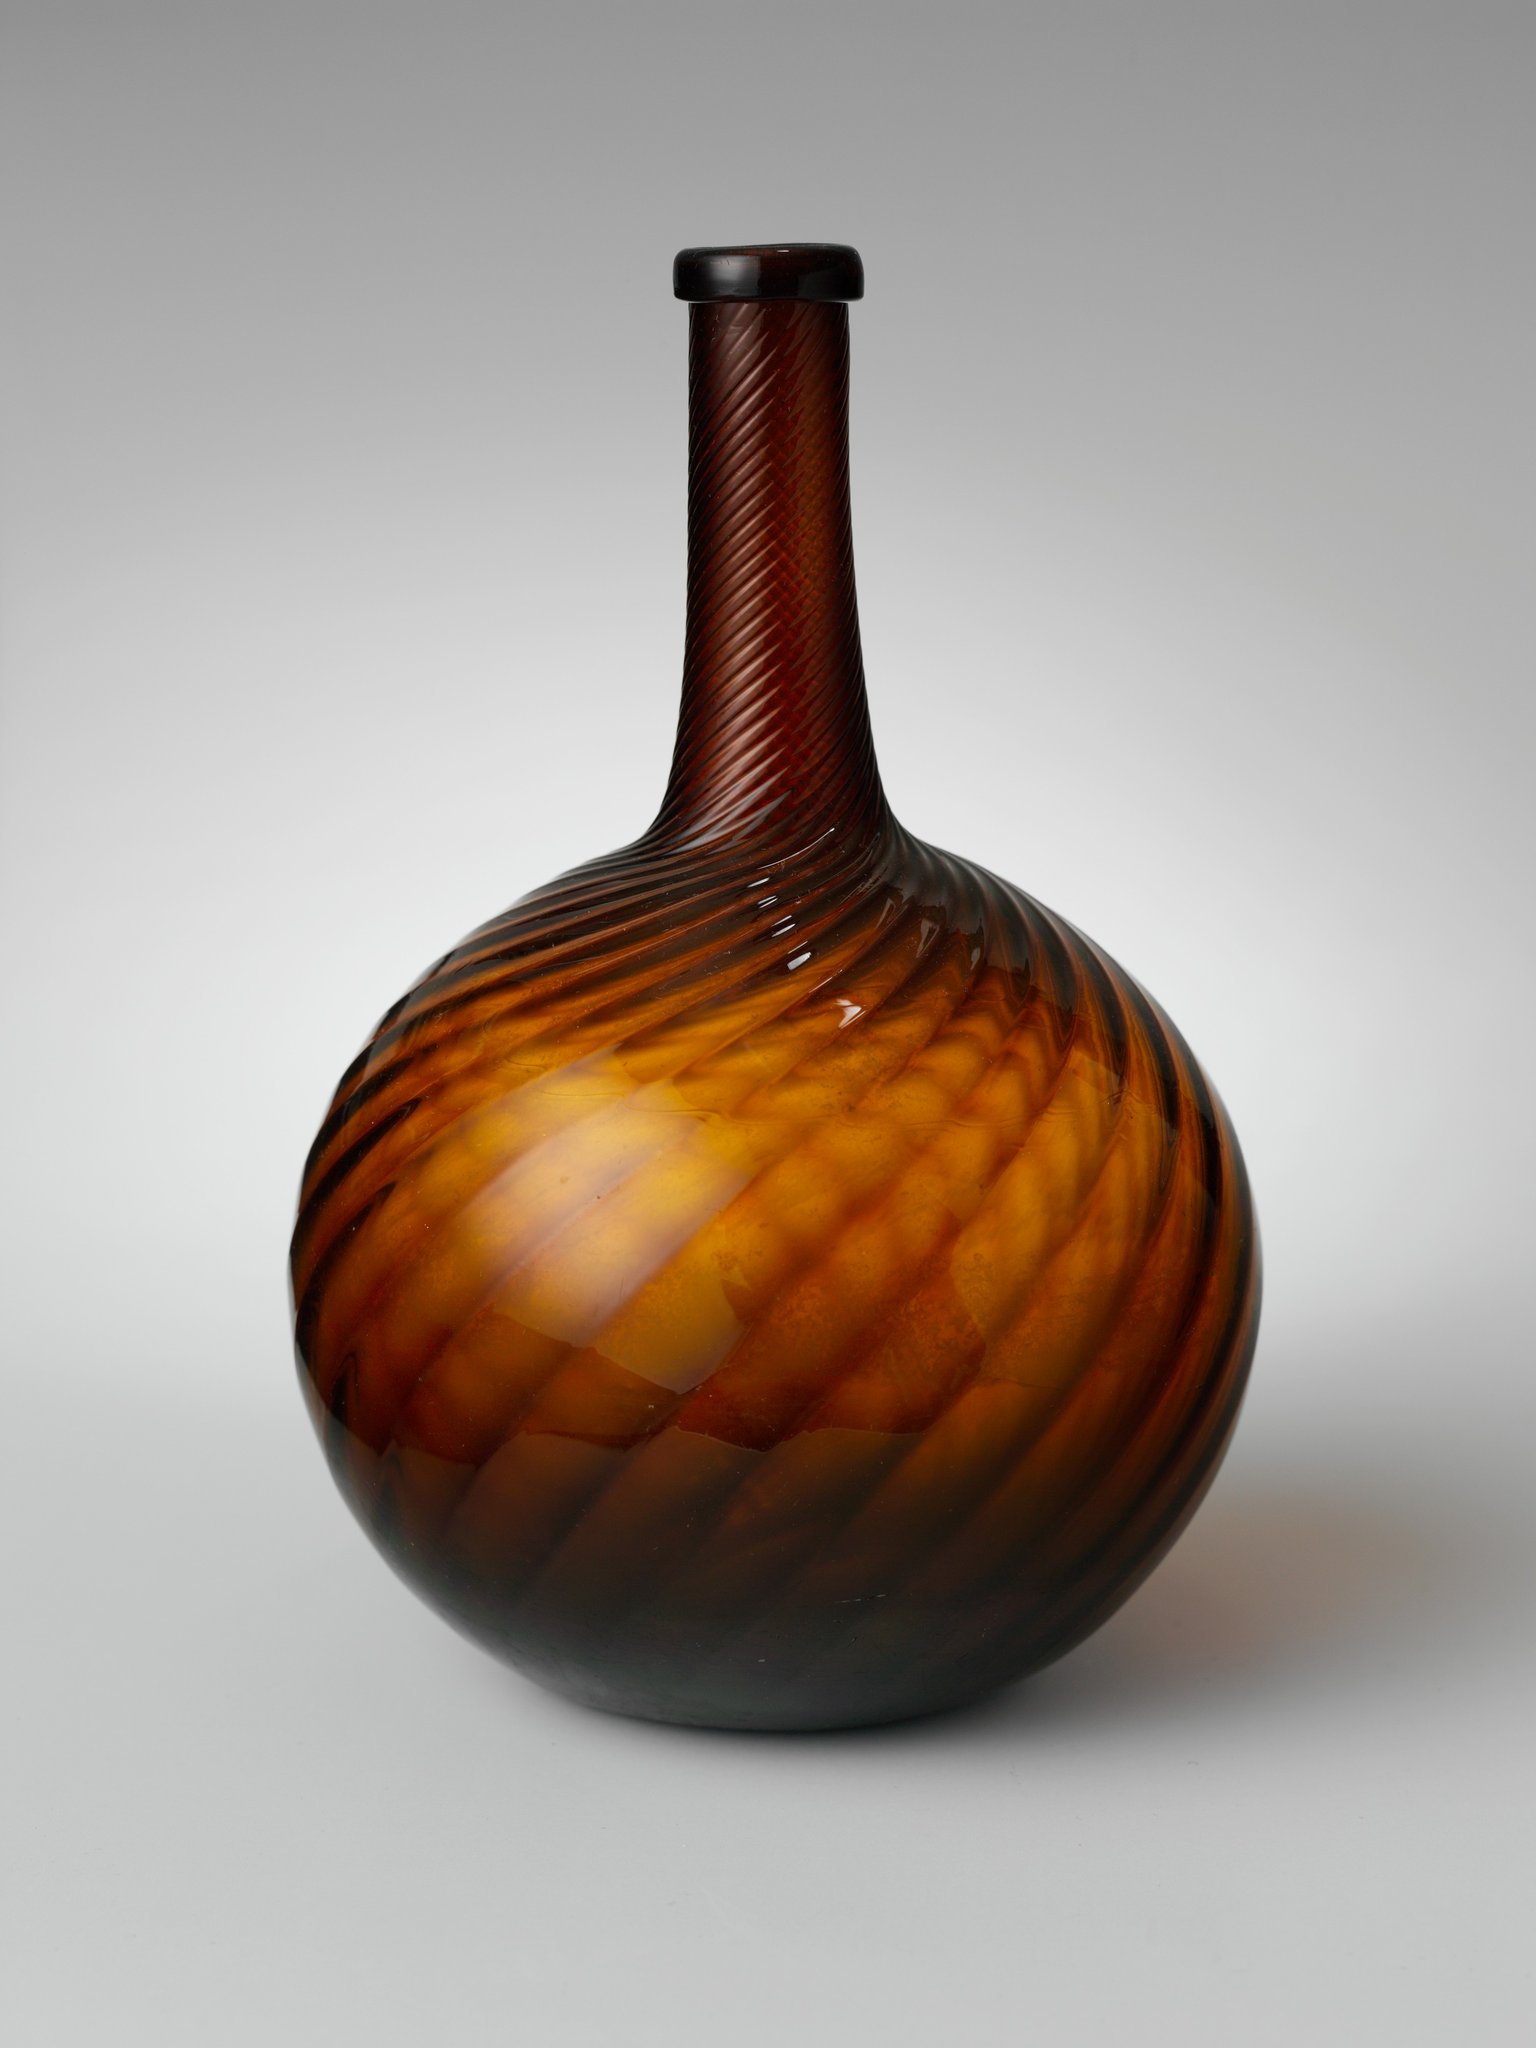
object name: bottle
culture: american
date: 1820-1840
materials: glass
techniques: glassblowing, molding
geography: united states